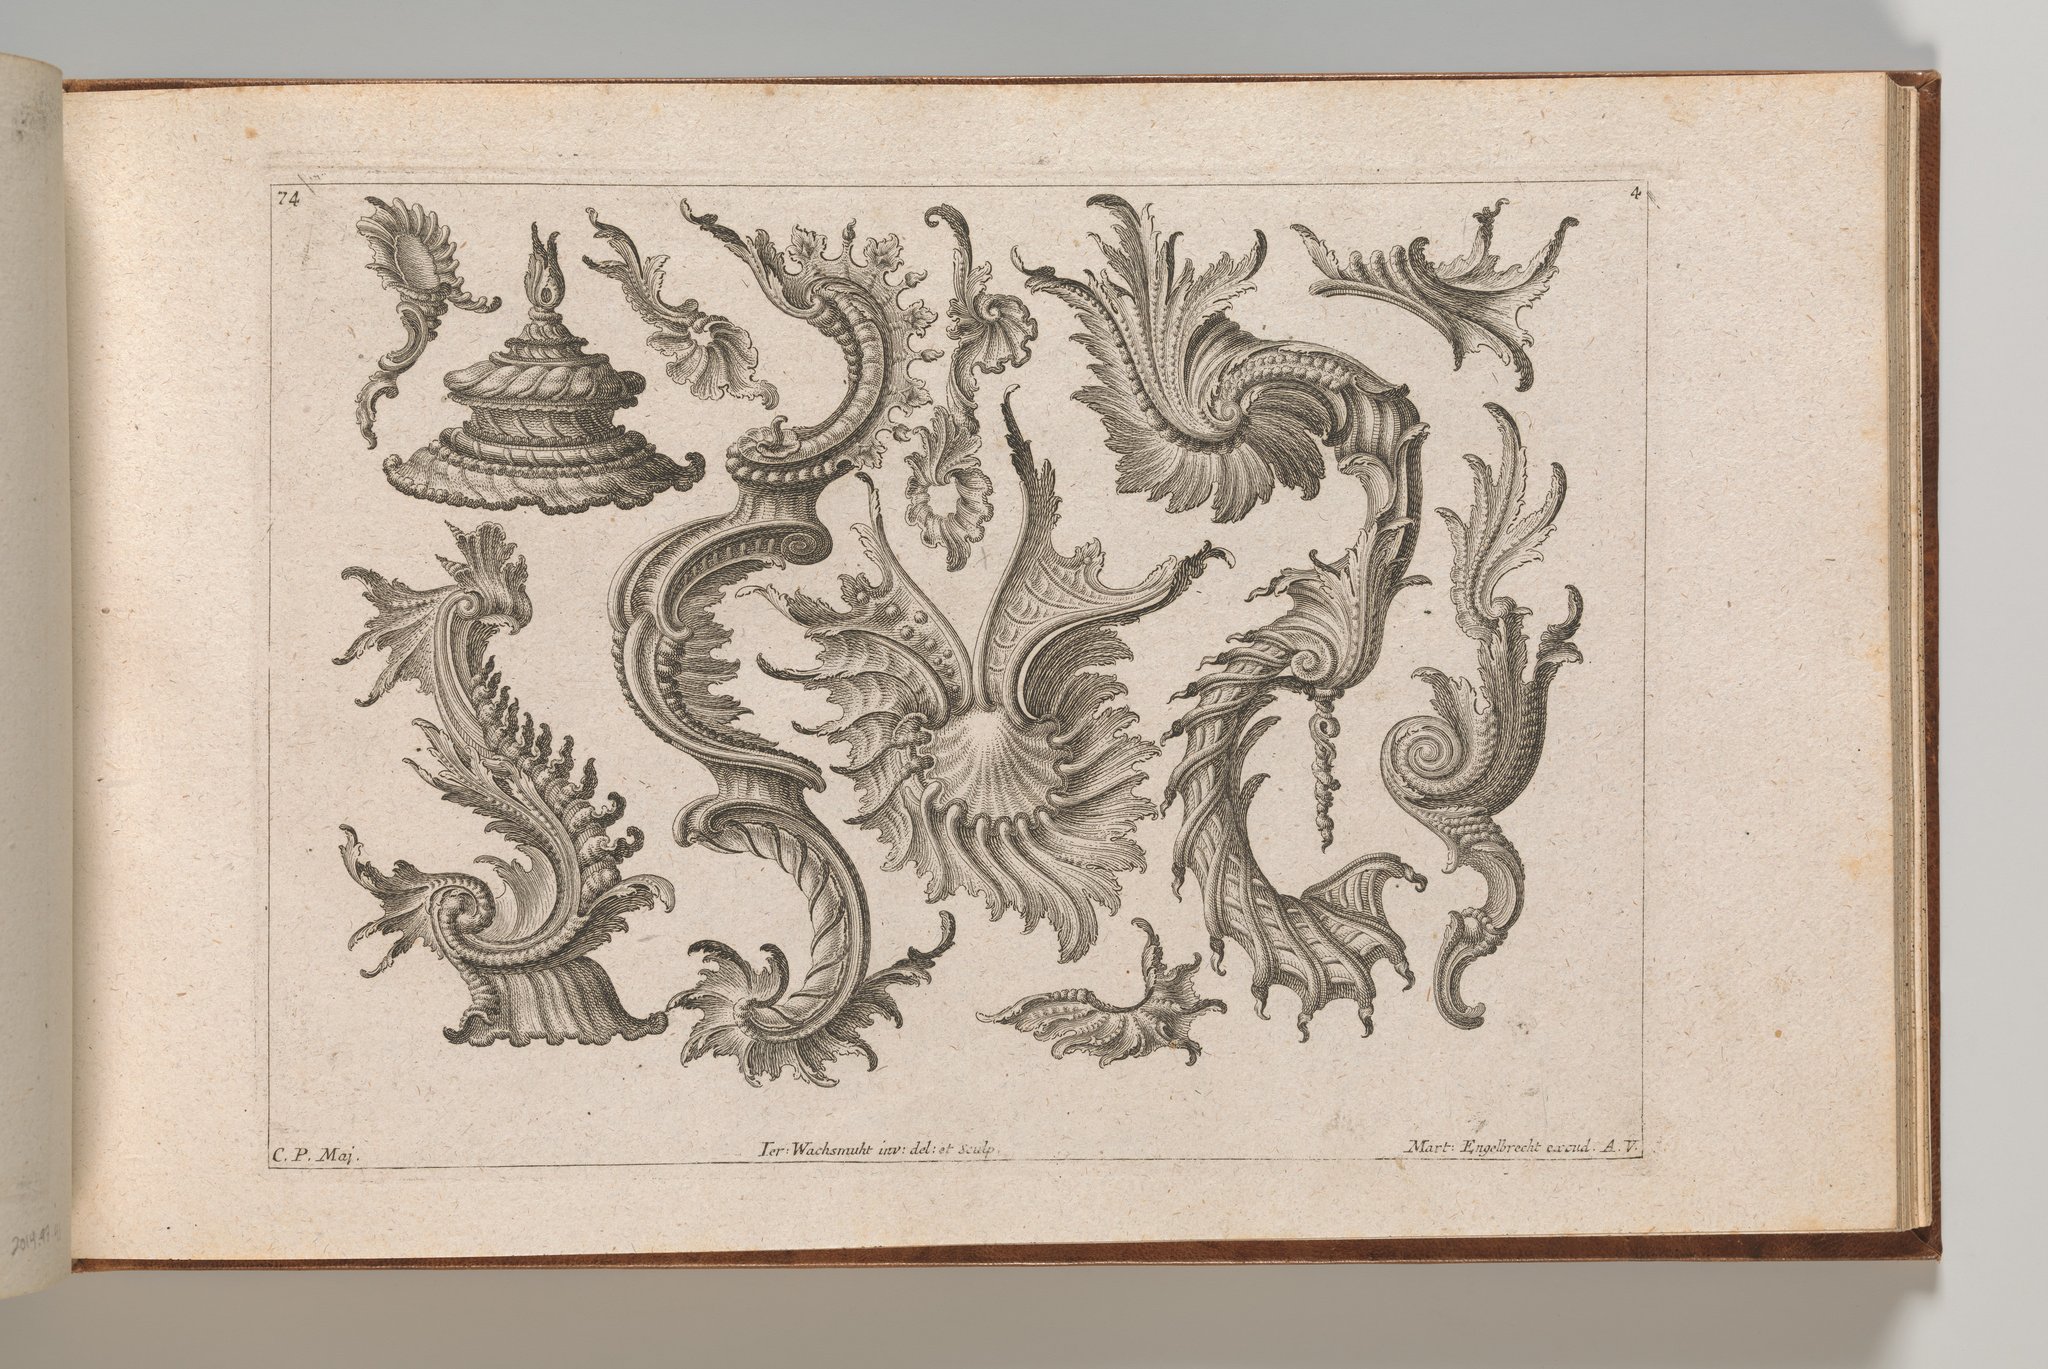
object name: album print ornament architecture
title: Various Designs for Rocaille Ornaments, Plate 4 from: 'Fortsezung von unterschielichen Auszierungen zu allerleij nüzlich anzuwenden'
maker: jeremias wachsmuth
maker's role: artist and engraver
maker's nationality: german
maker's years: 1712-1771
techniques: etching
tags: ornament